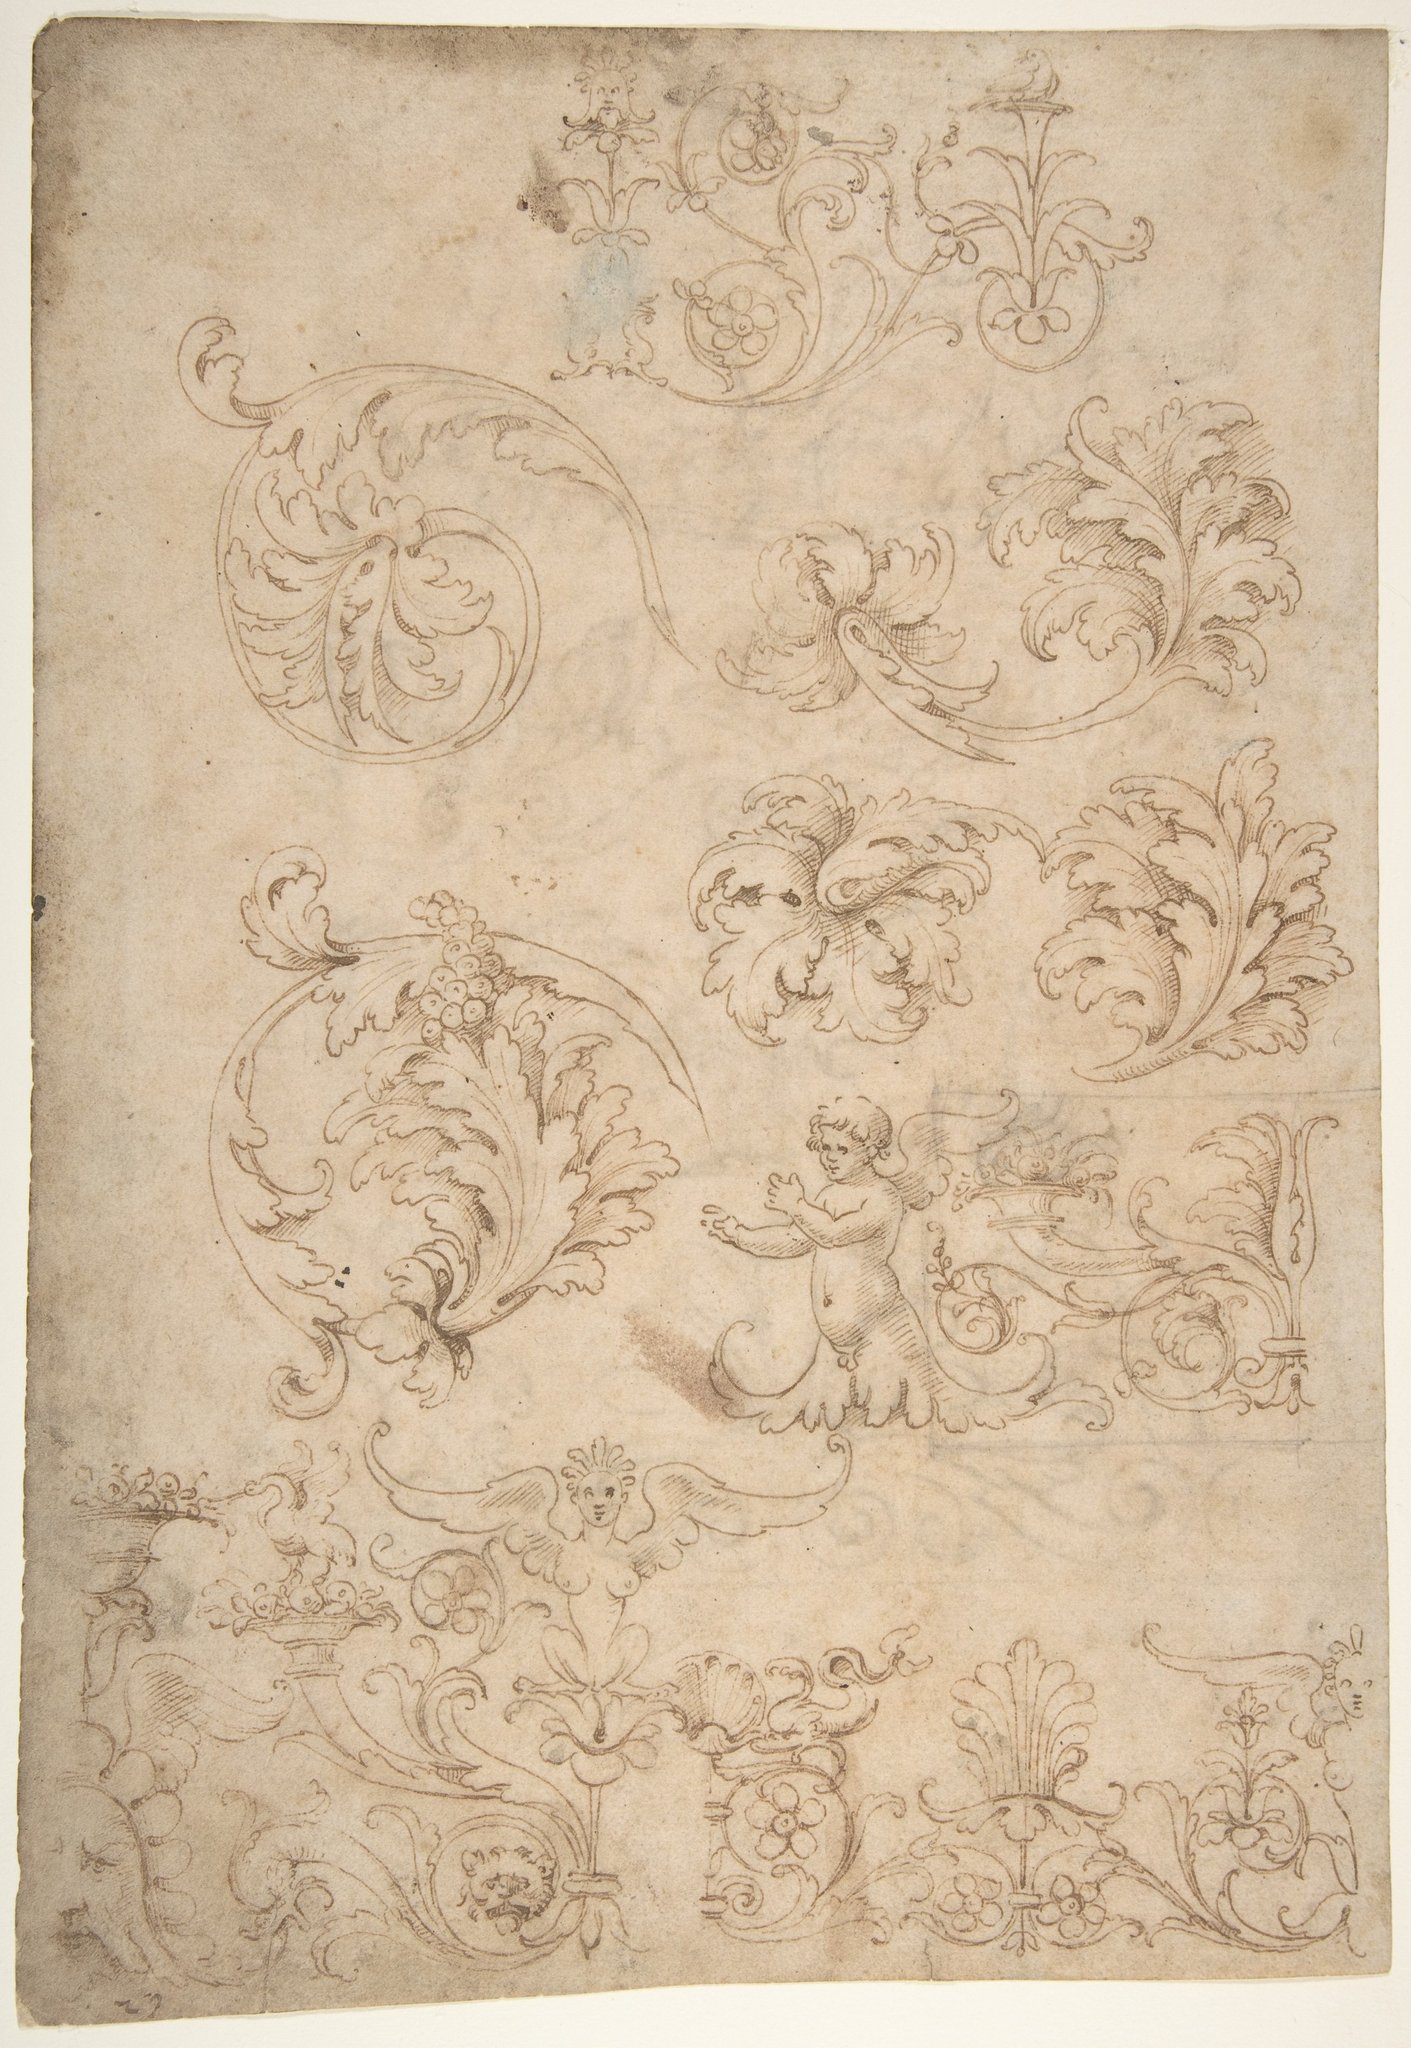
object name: drawing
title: Sketchbook Sheet of Ornamental Studies, (recto and verso)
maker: giovanni da udine (giovanni dei ricamatori)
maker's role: artist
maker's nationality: italian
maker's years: 1487-1564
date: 1487-1564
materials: ink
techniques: pen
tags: ornament